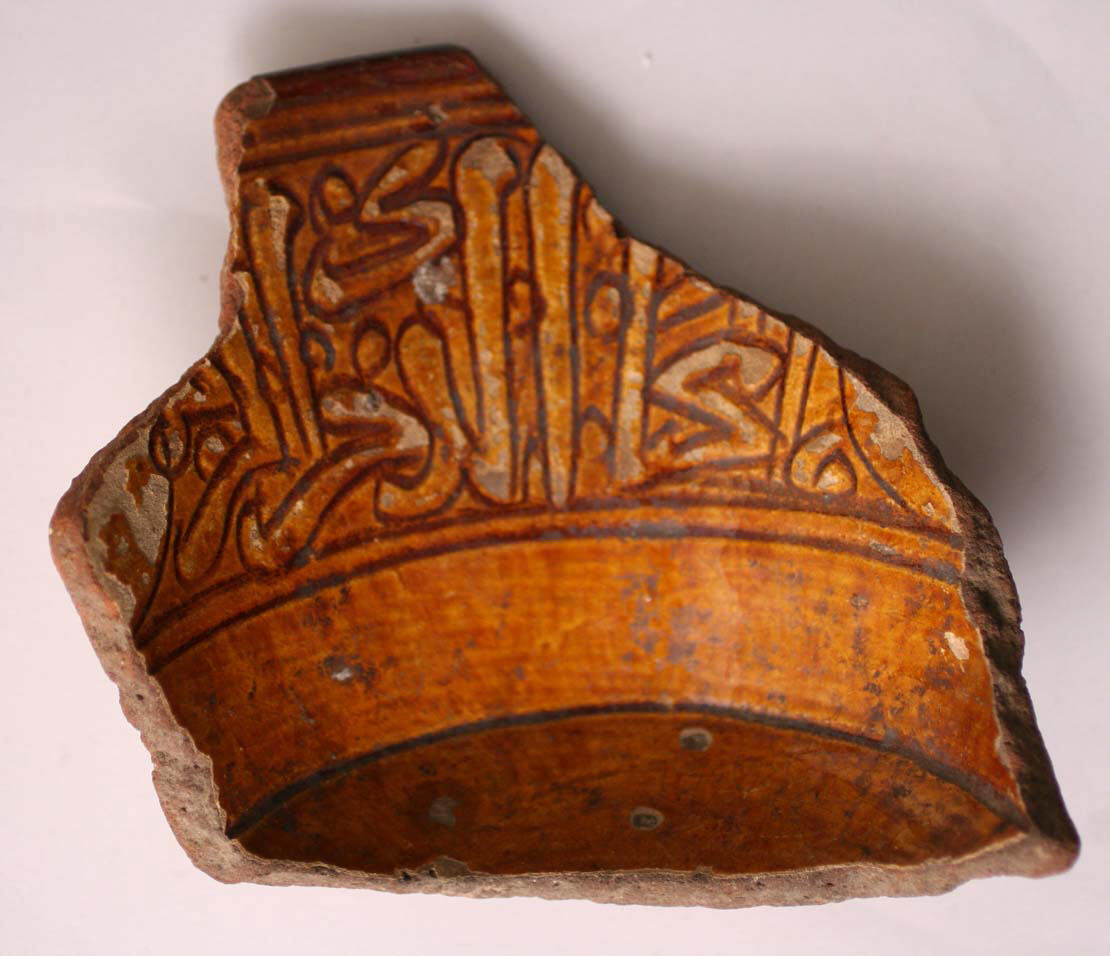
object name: fragment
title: Fragment of a Bowl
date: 1301-1500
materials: earthenware, glaze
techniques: coloring, incising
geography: egypt